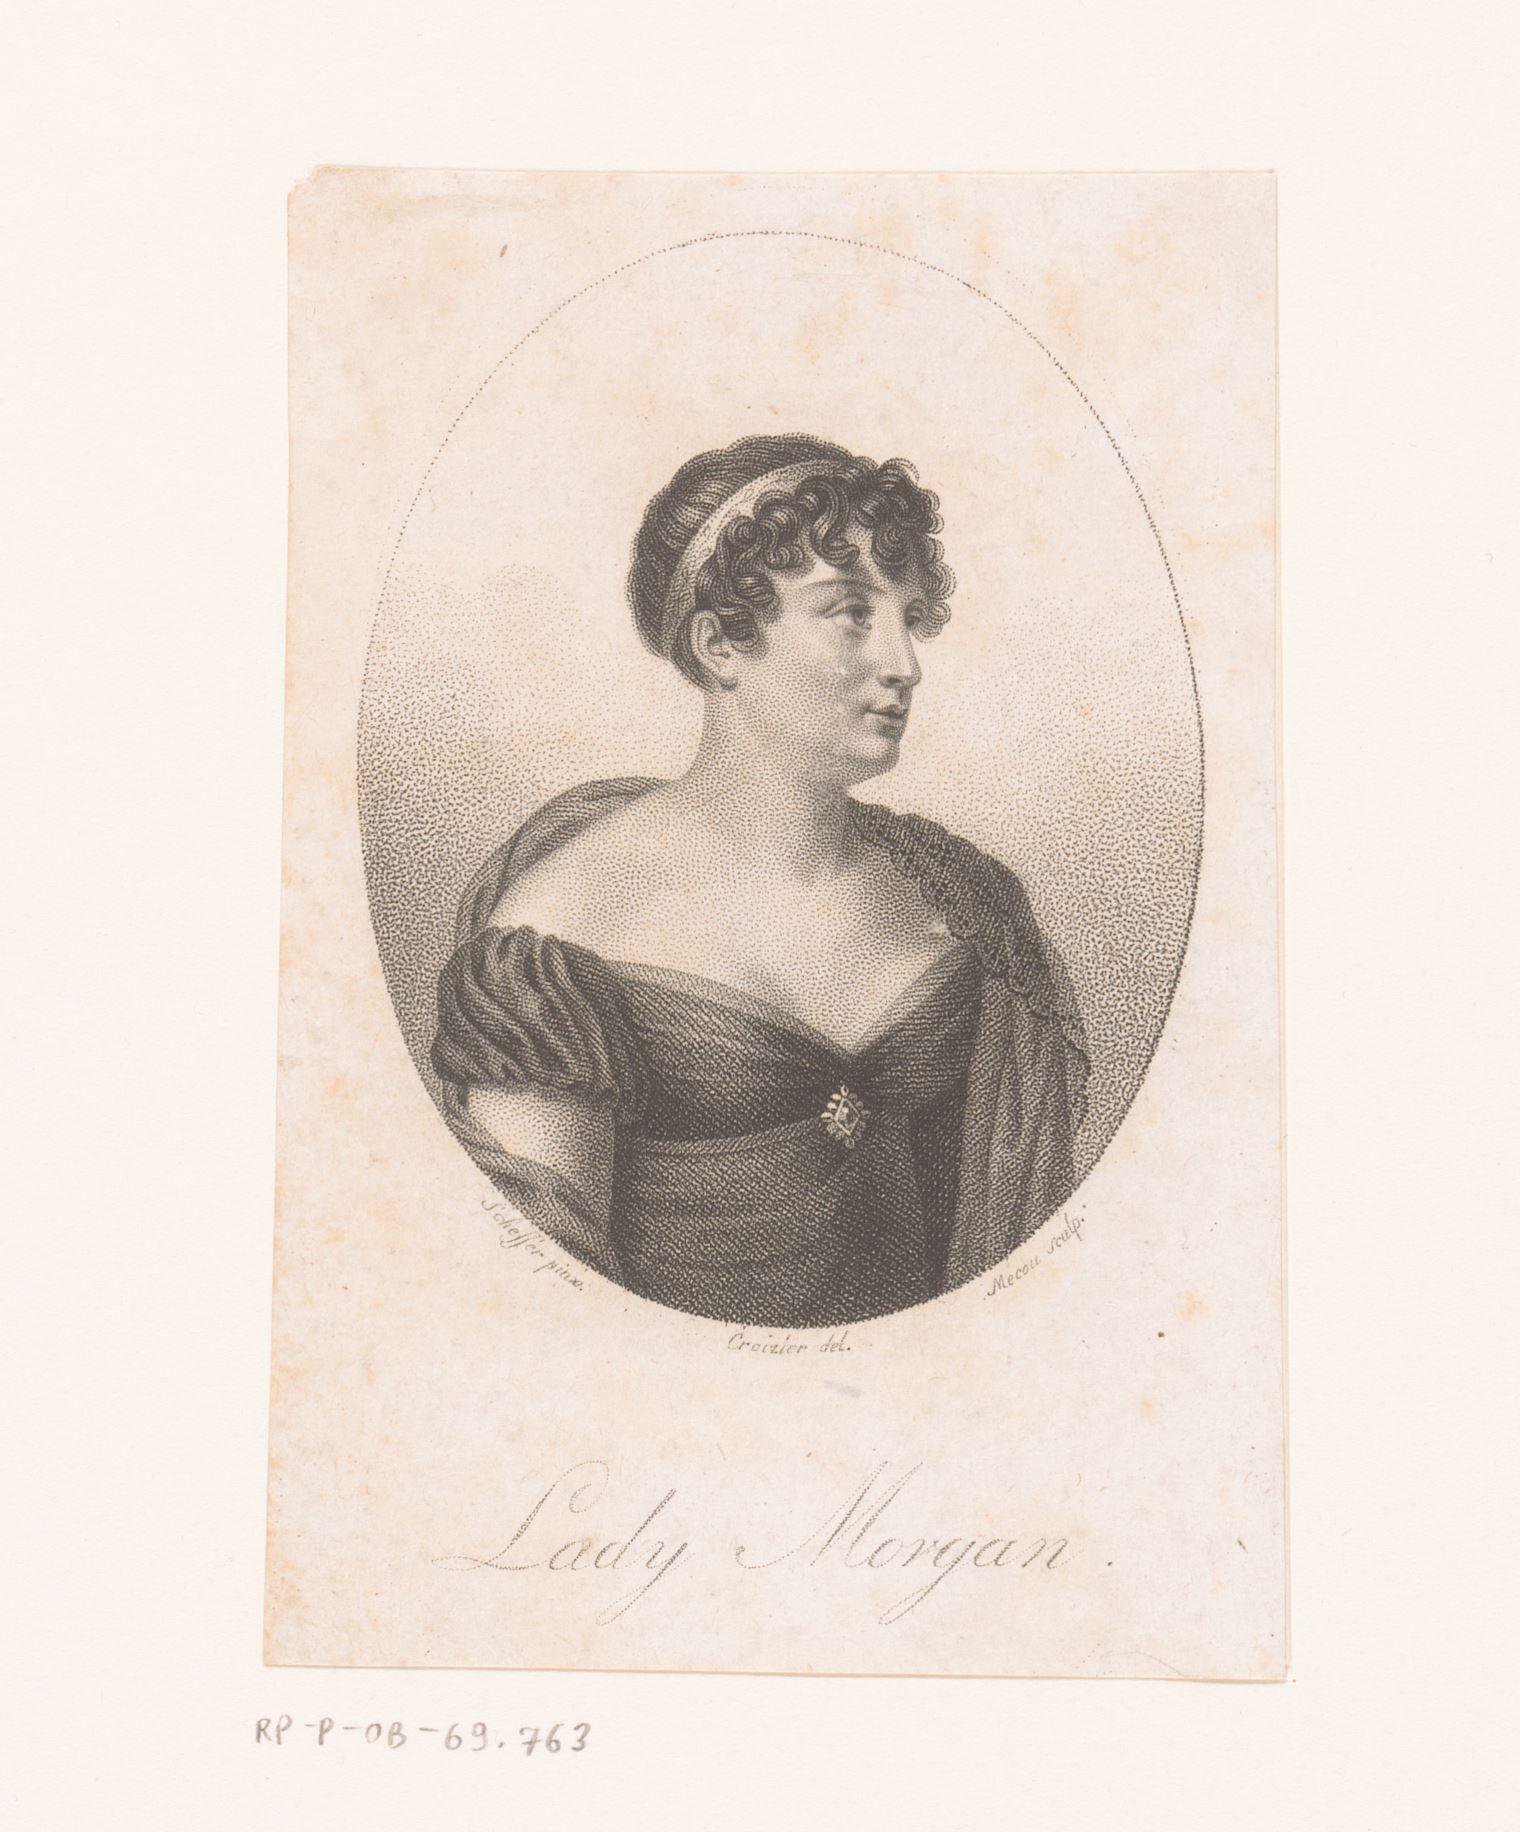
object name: print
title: Lady Morgan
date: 1800-1837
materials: paper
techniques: engraving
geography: france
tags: historical persons - bb - woman, portrait of a writer